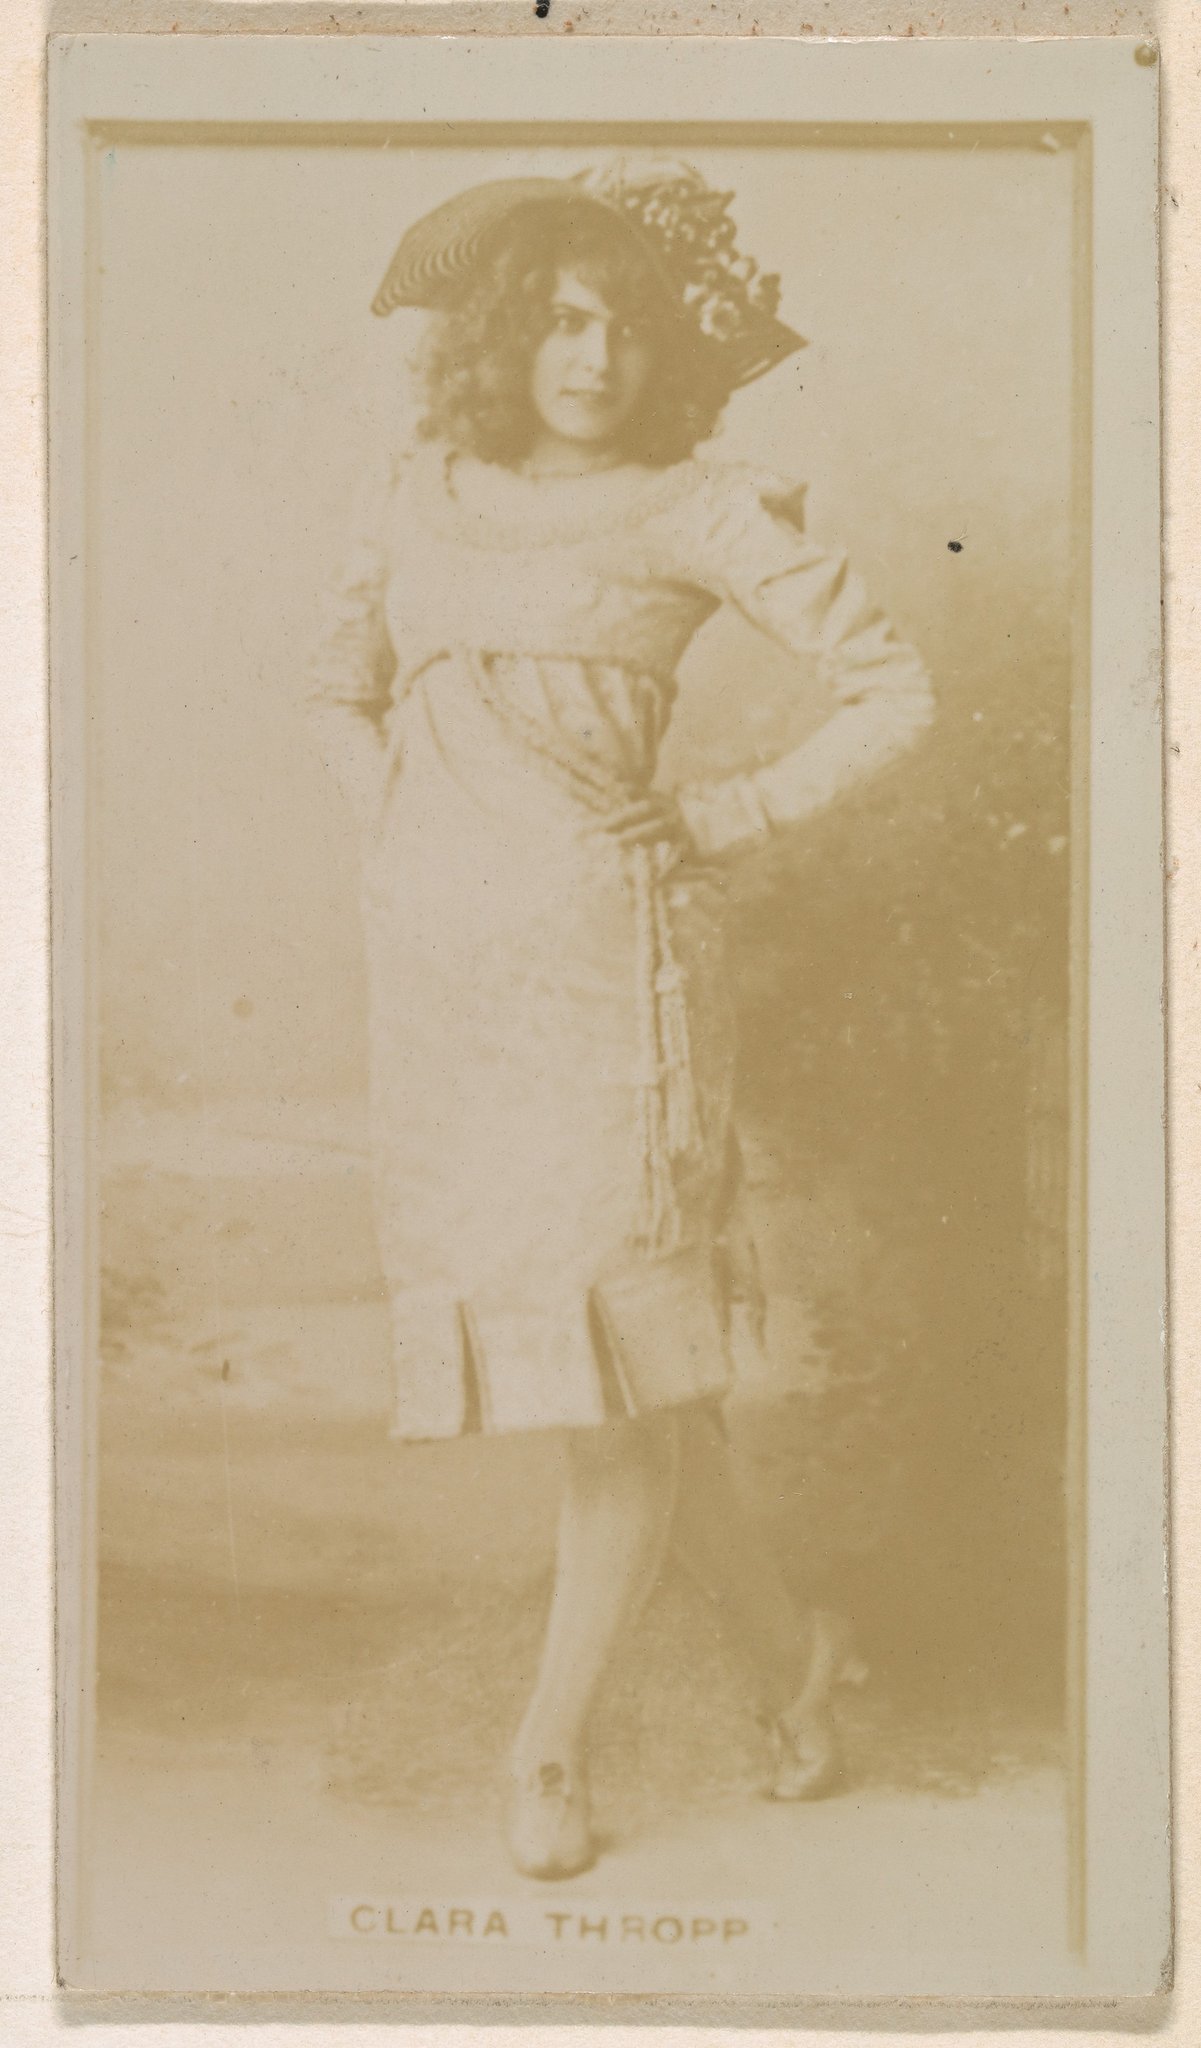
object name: photograph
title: Clara Thropp, from the Actresses series (N245) issued by Kinney Brothers to promote Sweet Caporal Cigarettes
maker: kinney brothers tobacco company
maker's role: publisher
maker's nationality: american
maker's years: 1869-2011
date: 1890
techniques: albumen silver print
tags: portraits,women,actresses